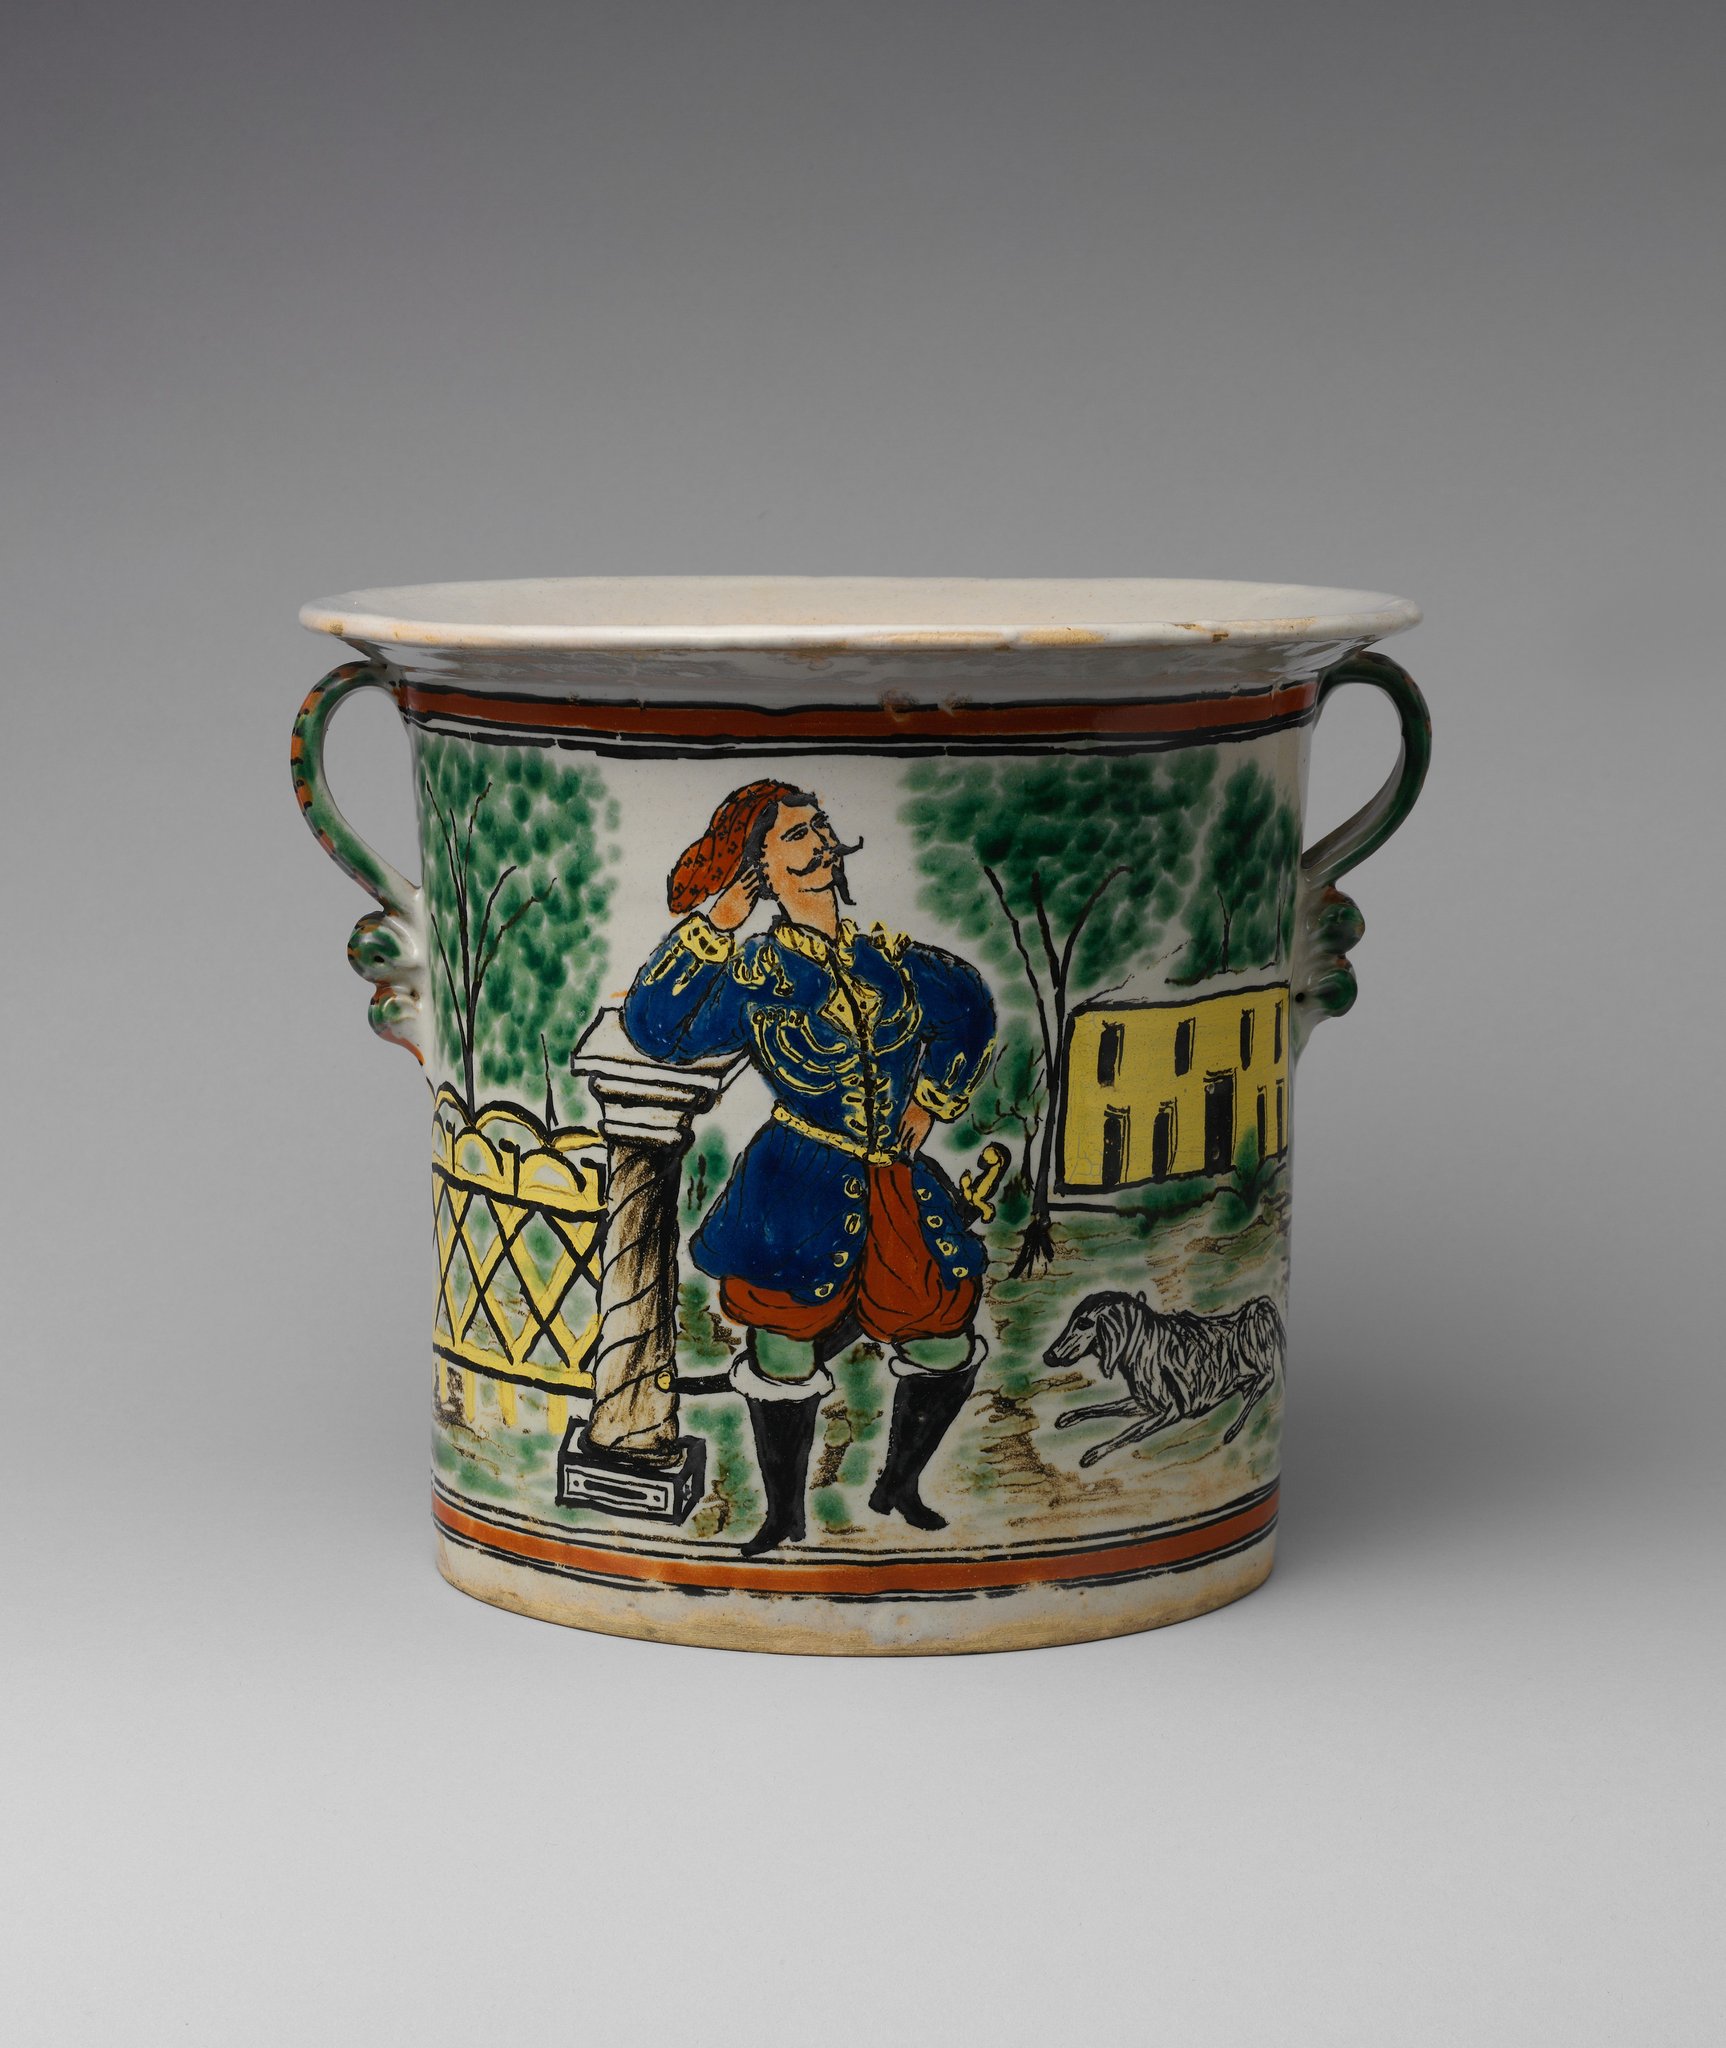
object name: jar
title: Chamber Pot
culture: mexican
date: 1865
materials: earthenware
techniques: glazing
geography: mexico